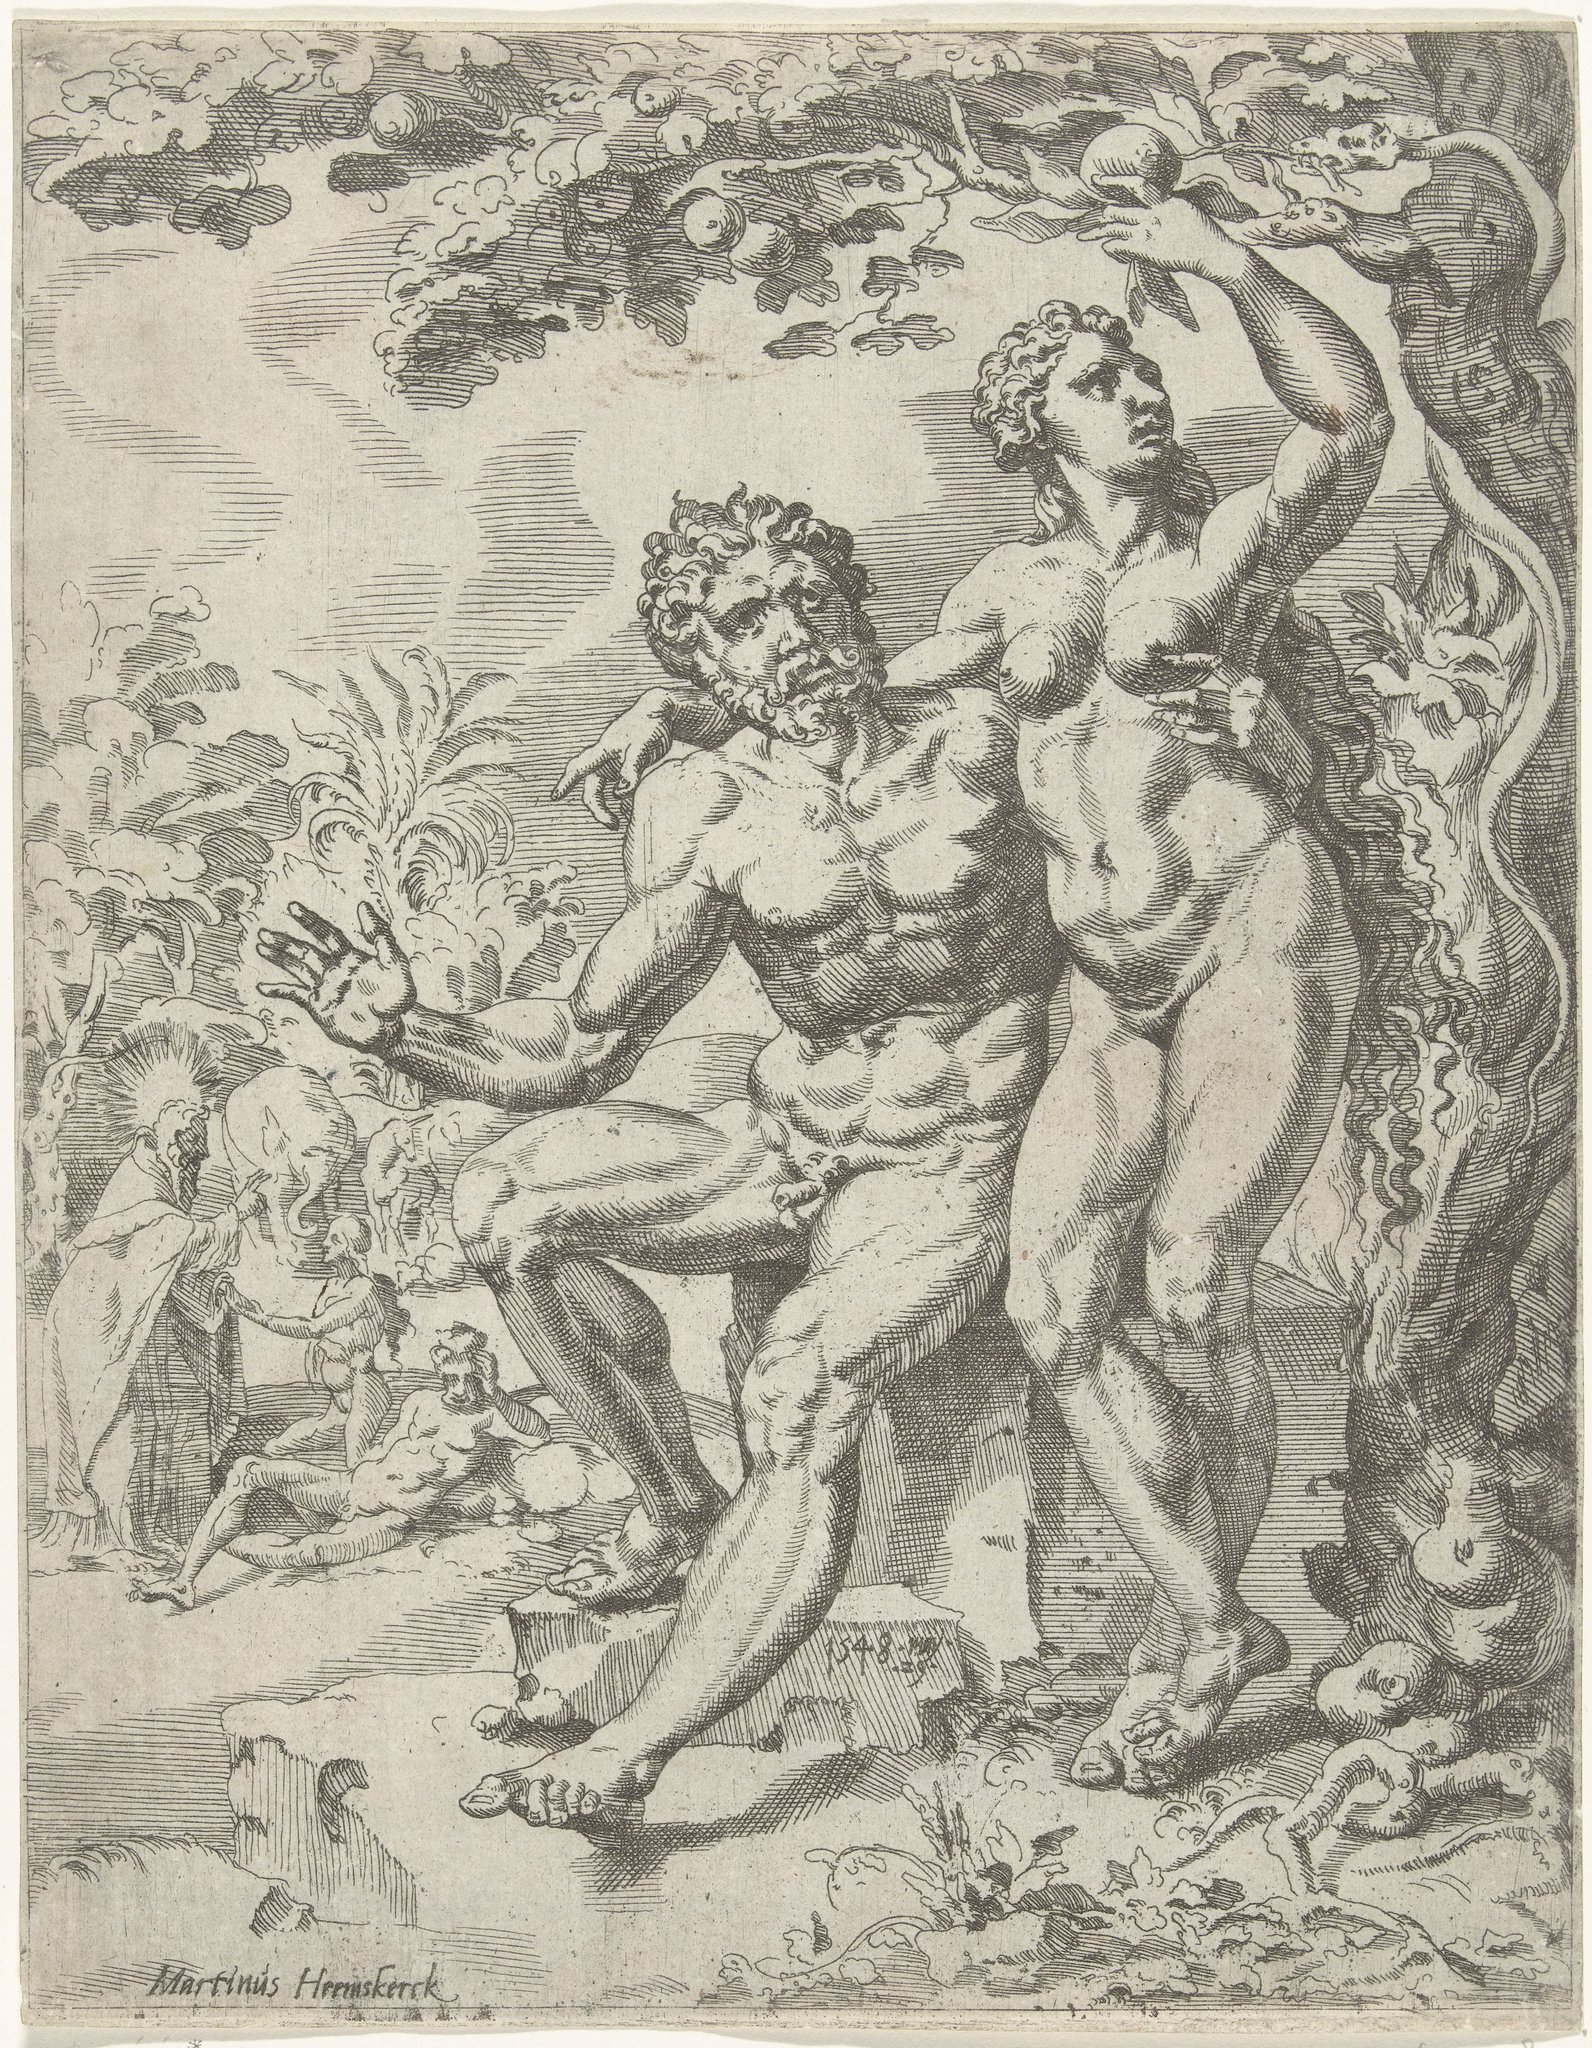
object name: print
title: Val en de verlossing van de mensheid door het leven en passie van Christus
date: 1548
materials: paper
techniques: etching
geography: haarlem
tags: eve takes the fruit from the serpent (or the tree) in the presence of adam (who may be trying to stop her)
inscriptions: collector's mark: Lugt 2228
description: Eva plukt een vrucht van de boom van de kennis van goed en kwaad. Adam zit naast Eva en omarmt haar. Op de achtergrond schept God Eva uit Adams rib. De prent is deel van een dertigdelige serie met prenten over de zondeval en Christus' passie.